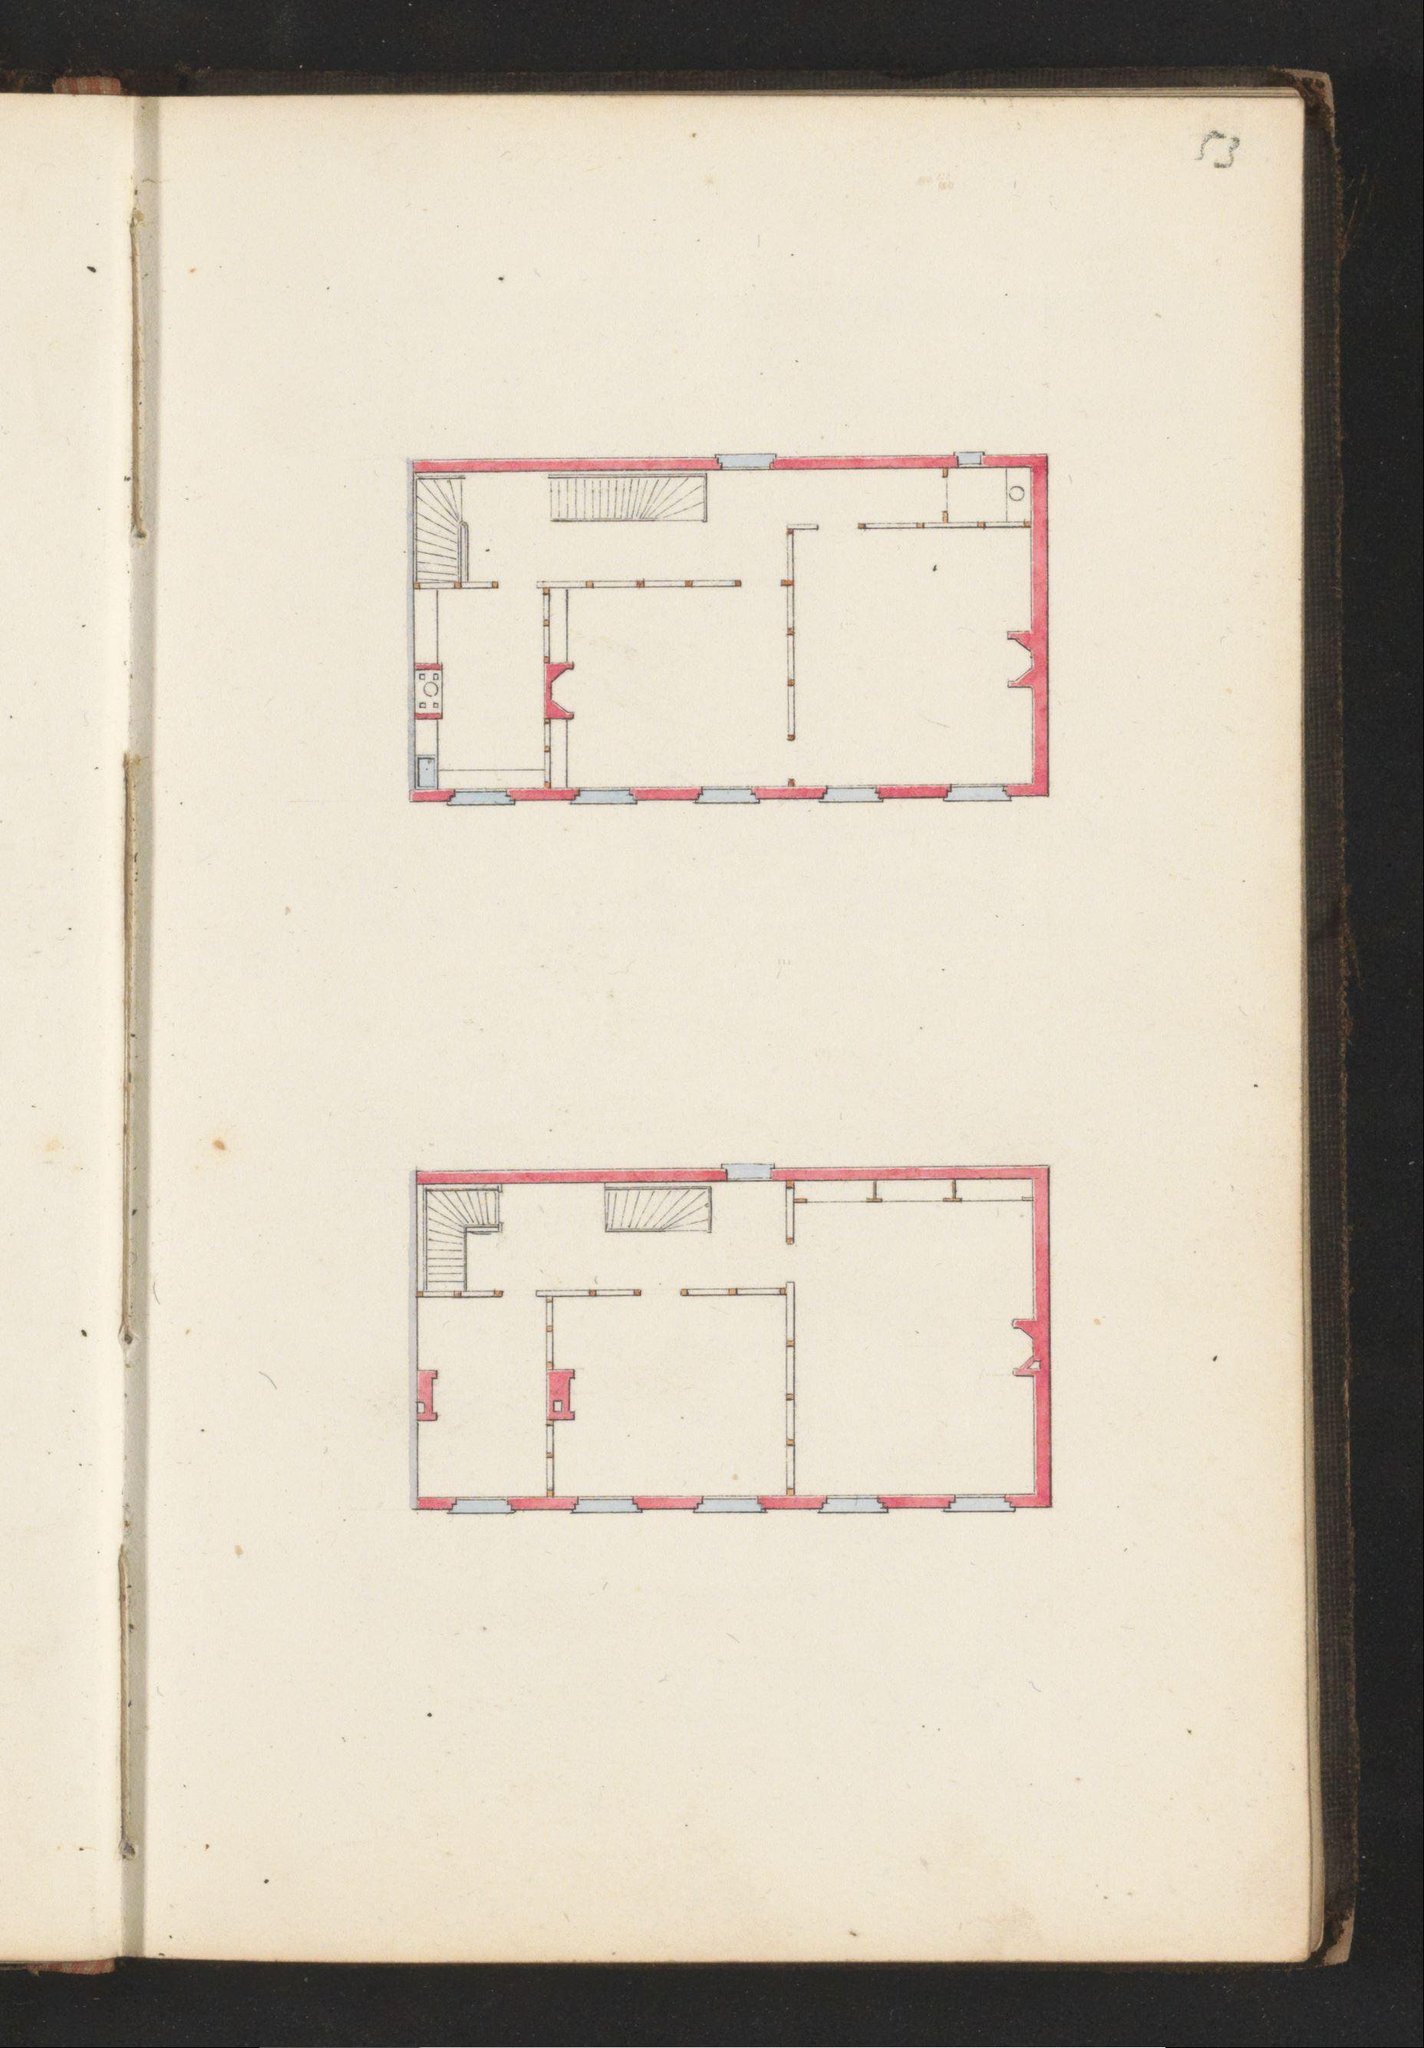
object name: sketchbook leaf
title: Plattegronden van twee verdiepingen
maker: willem springer jr.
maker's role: draughtsman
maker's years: 1815-1907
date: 1864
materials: ink, paper, watercolor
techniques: brush, pen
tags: plan ~ architecture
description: Pagina 53 uit een schetsboek met 164 pagina's.